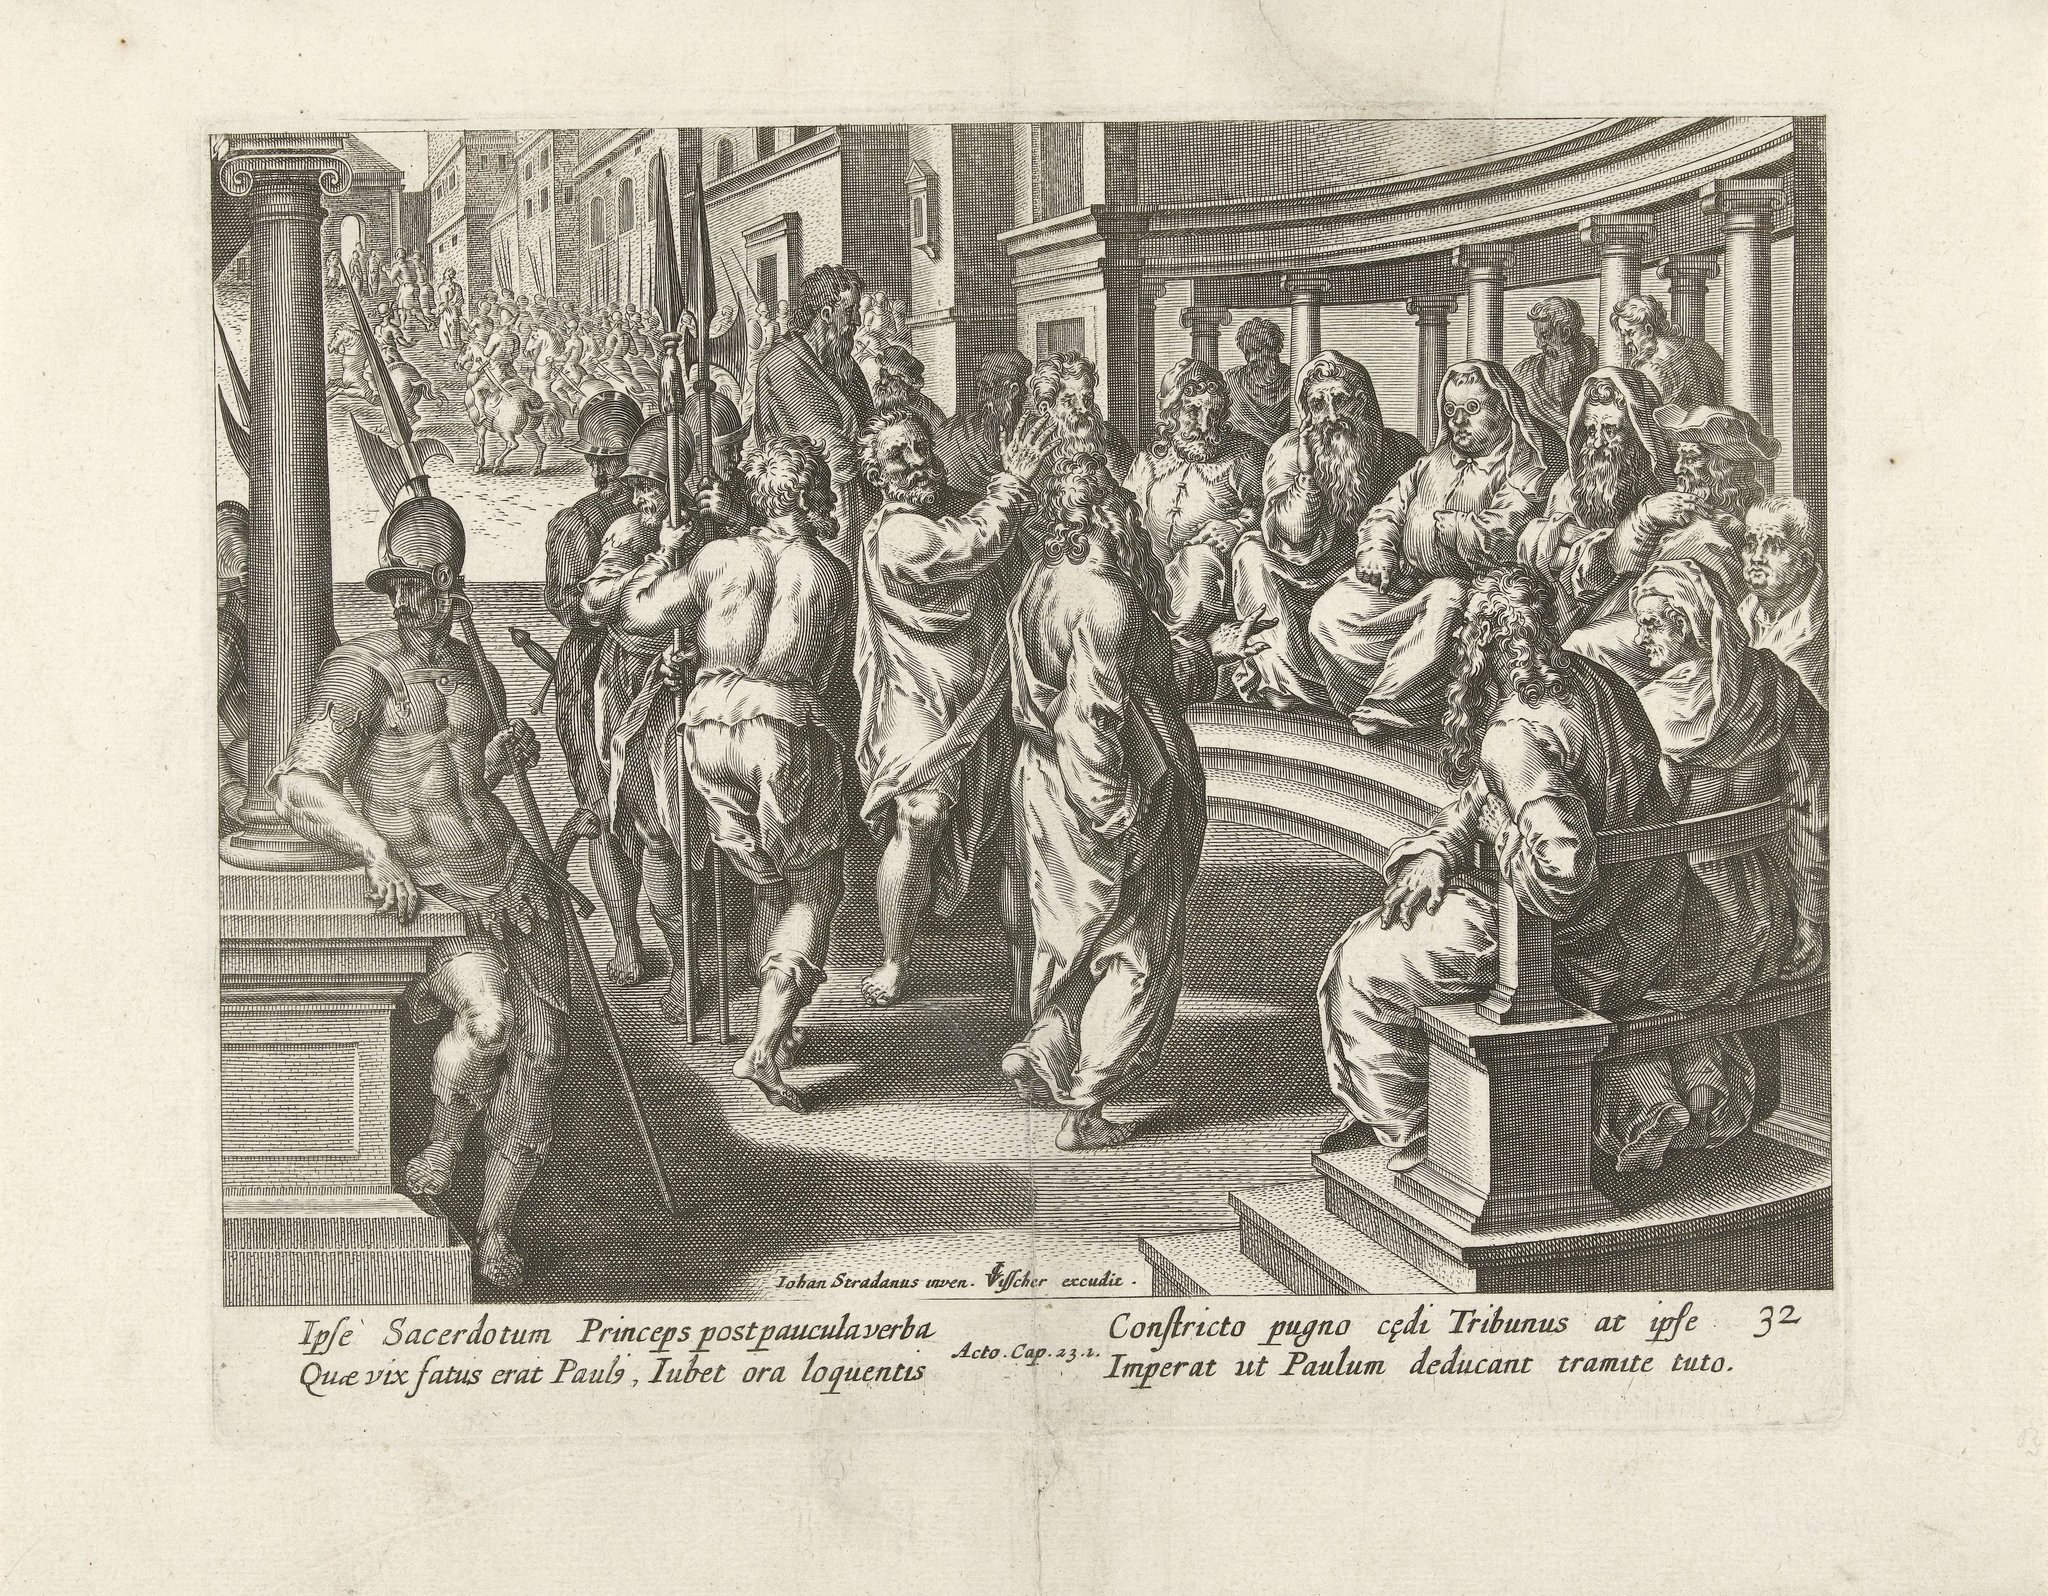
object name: print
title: Handelingen van de apostelen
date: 1643-1646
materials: paper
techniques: engraving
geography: antwerp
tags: paul before the high priest ananias and the sanhedrin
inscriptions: collector's mark: Lugt 2228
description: De apostel Paulus moet zich verdedigen voor het tribunaal van het Sanhedrin. De prent heeft een Latijns onderschrift en maakt deel uit van een 35-delige serie met als onderwerp de Handelingen van de apostelen.